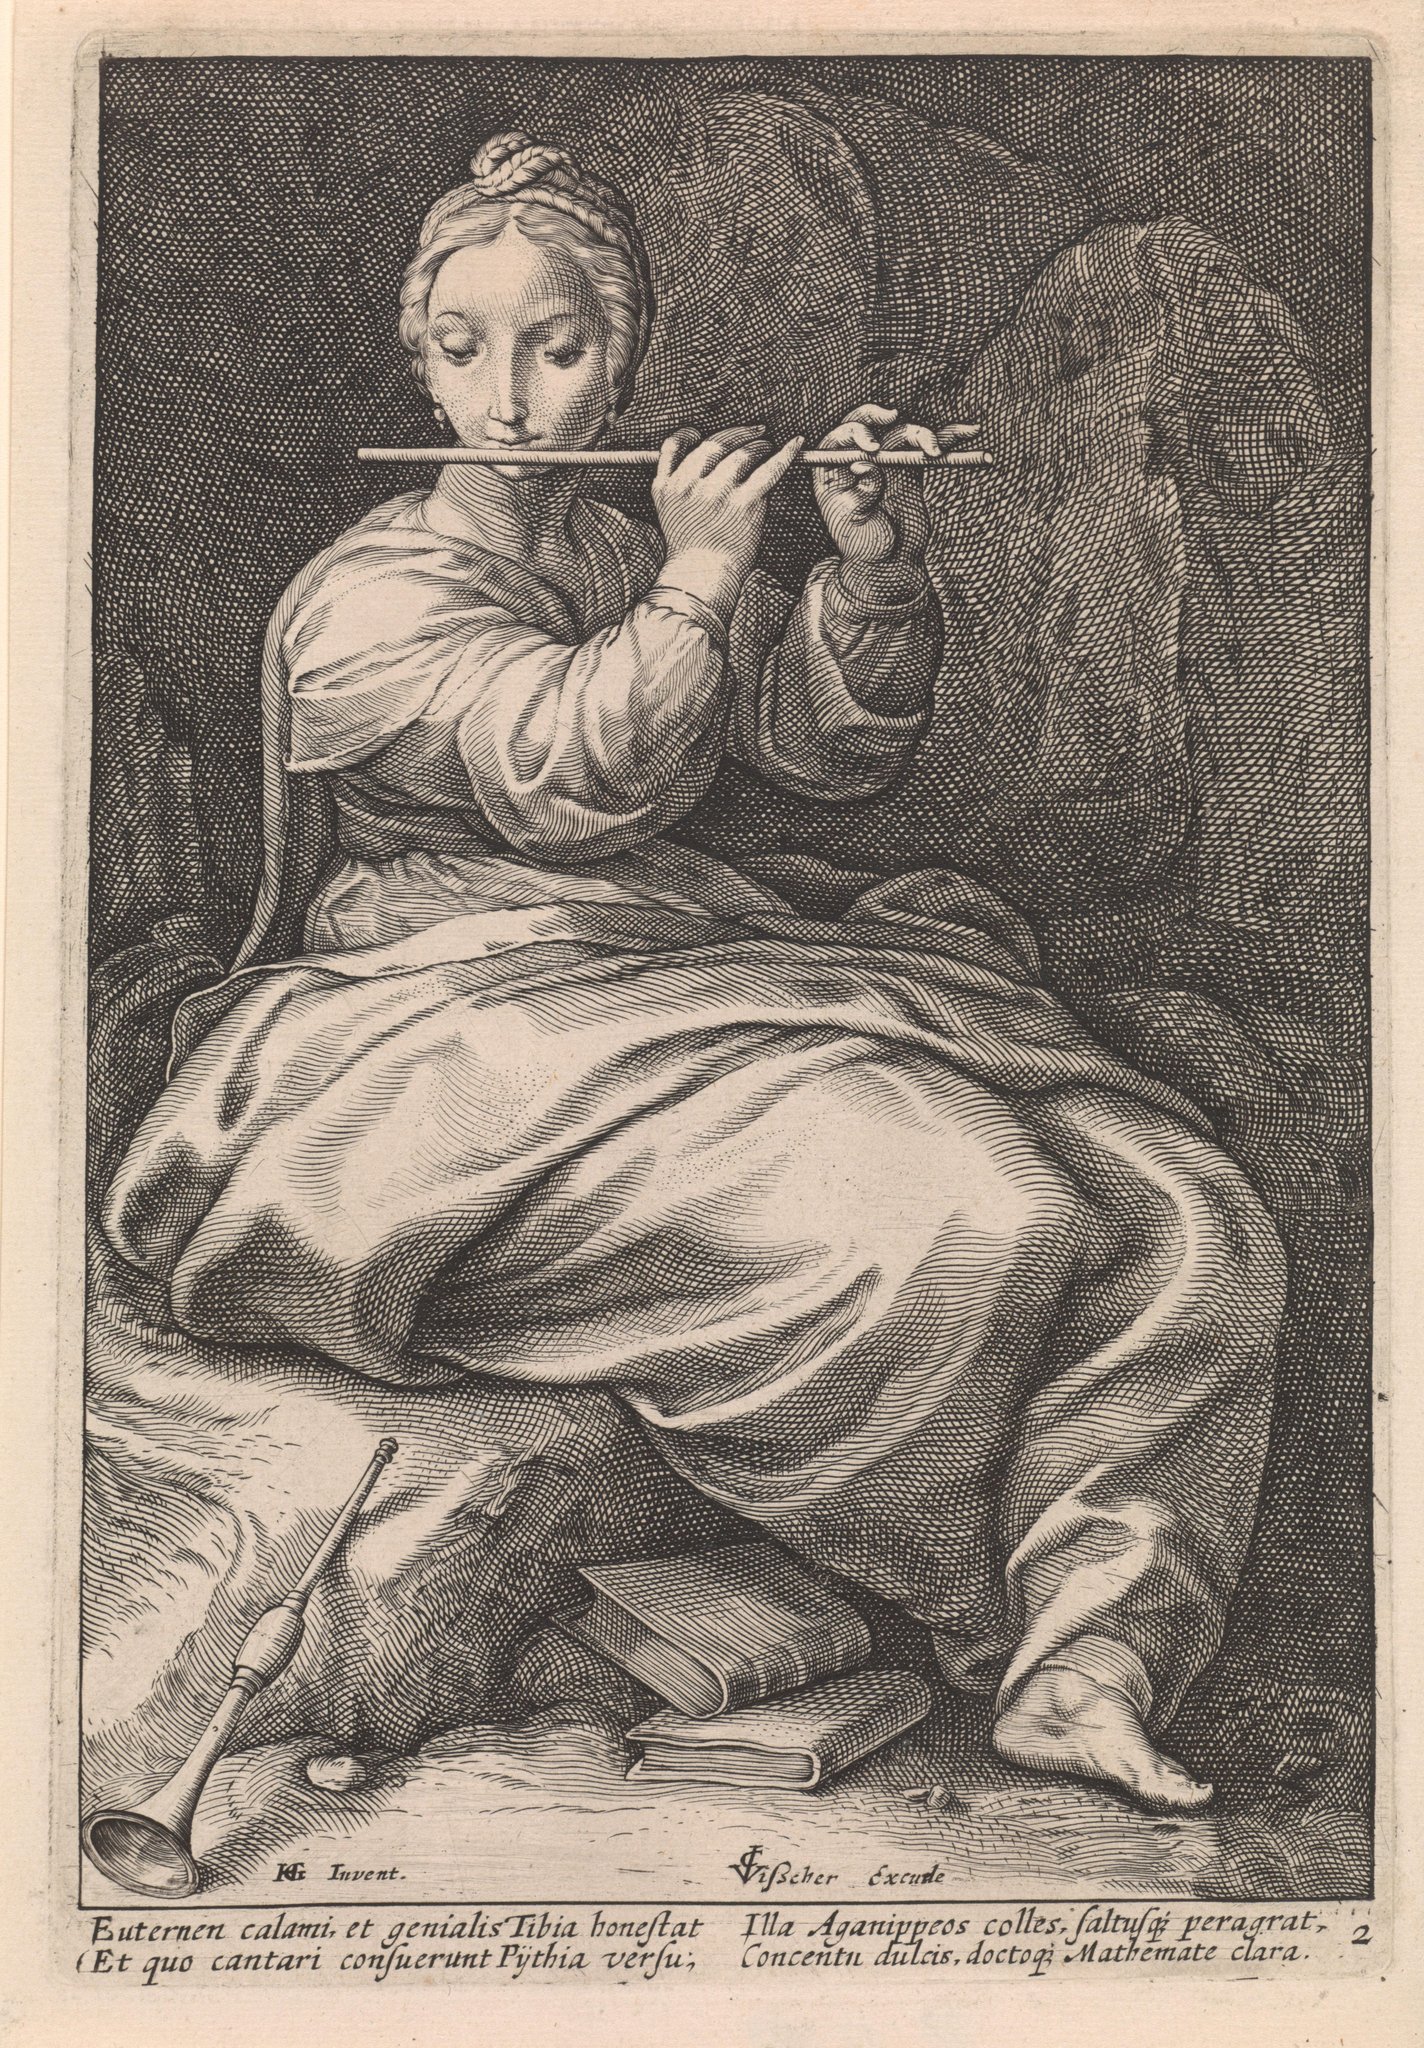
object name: print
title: De negen muzen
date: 1601-1652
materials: paper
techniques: engraving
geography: amsterdam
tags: euterpe (one of the muses); 'euterpe' (ripa)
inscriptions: collector's mark: Lugt 2228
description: De zittende Euterpe, de muze van de muziek en lyriek, bespeelt de dwarsfluit en aan haar voeten liggen een klarinet en boeken. Onder de voorstelling twee tweeregelige verzen in het Latijn.